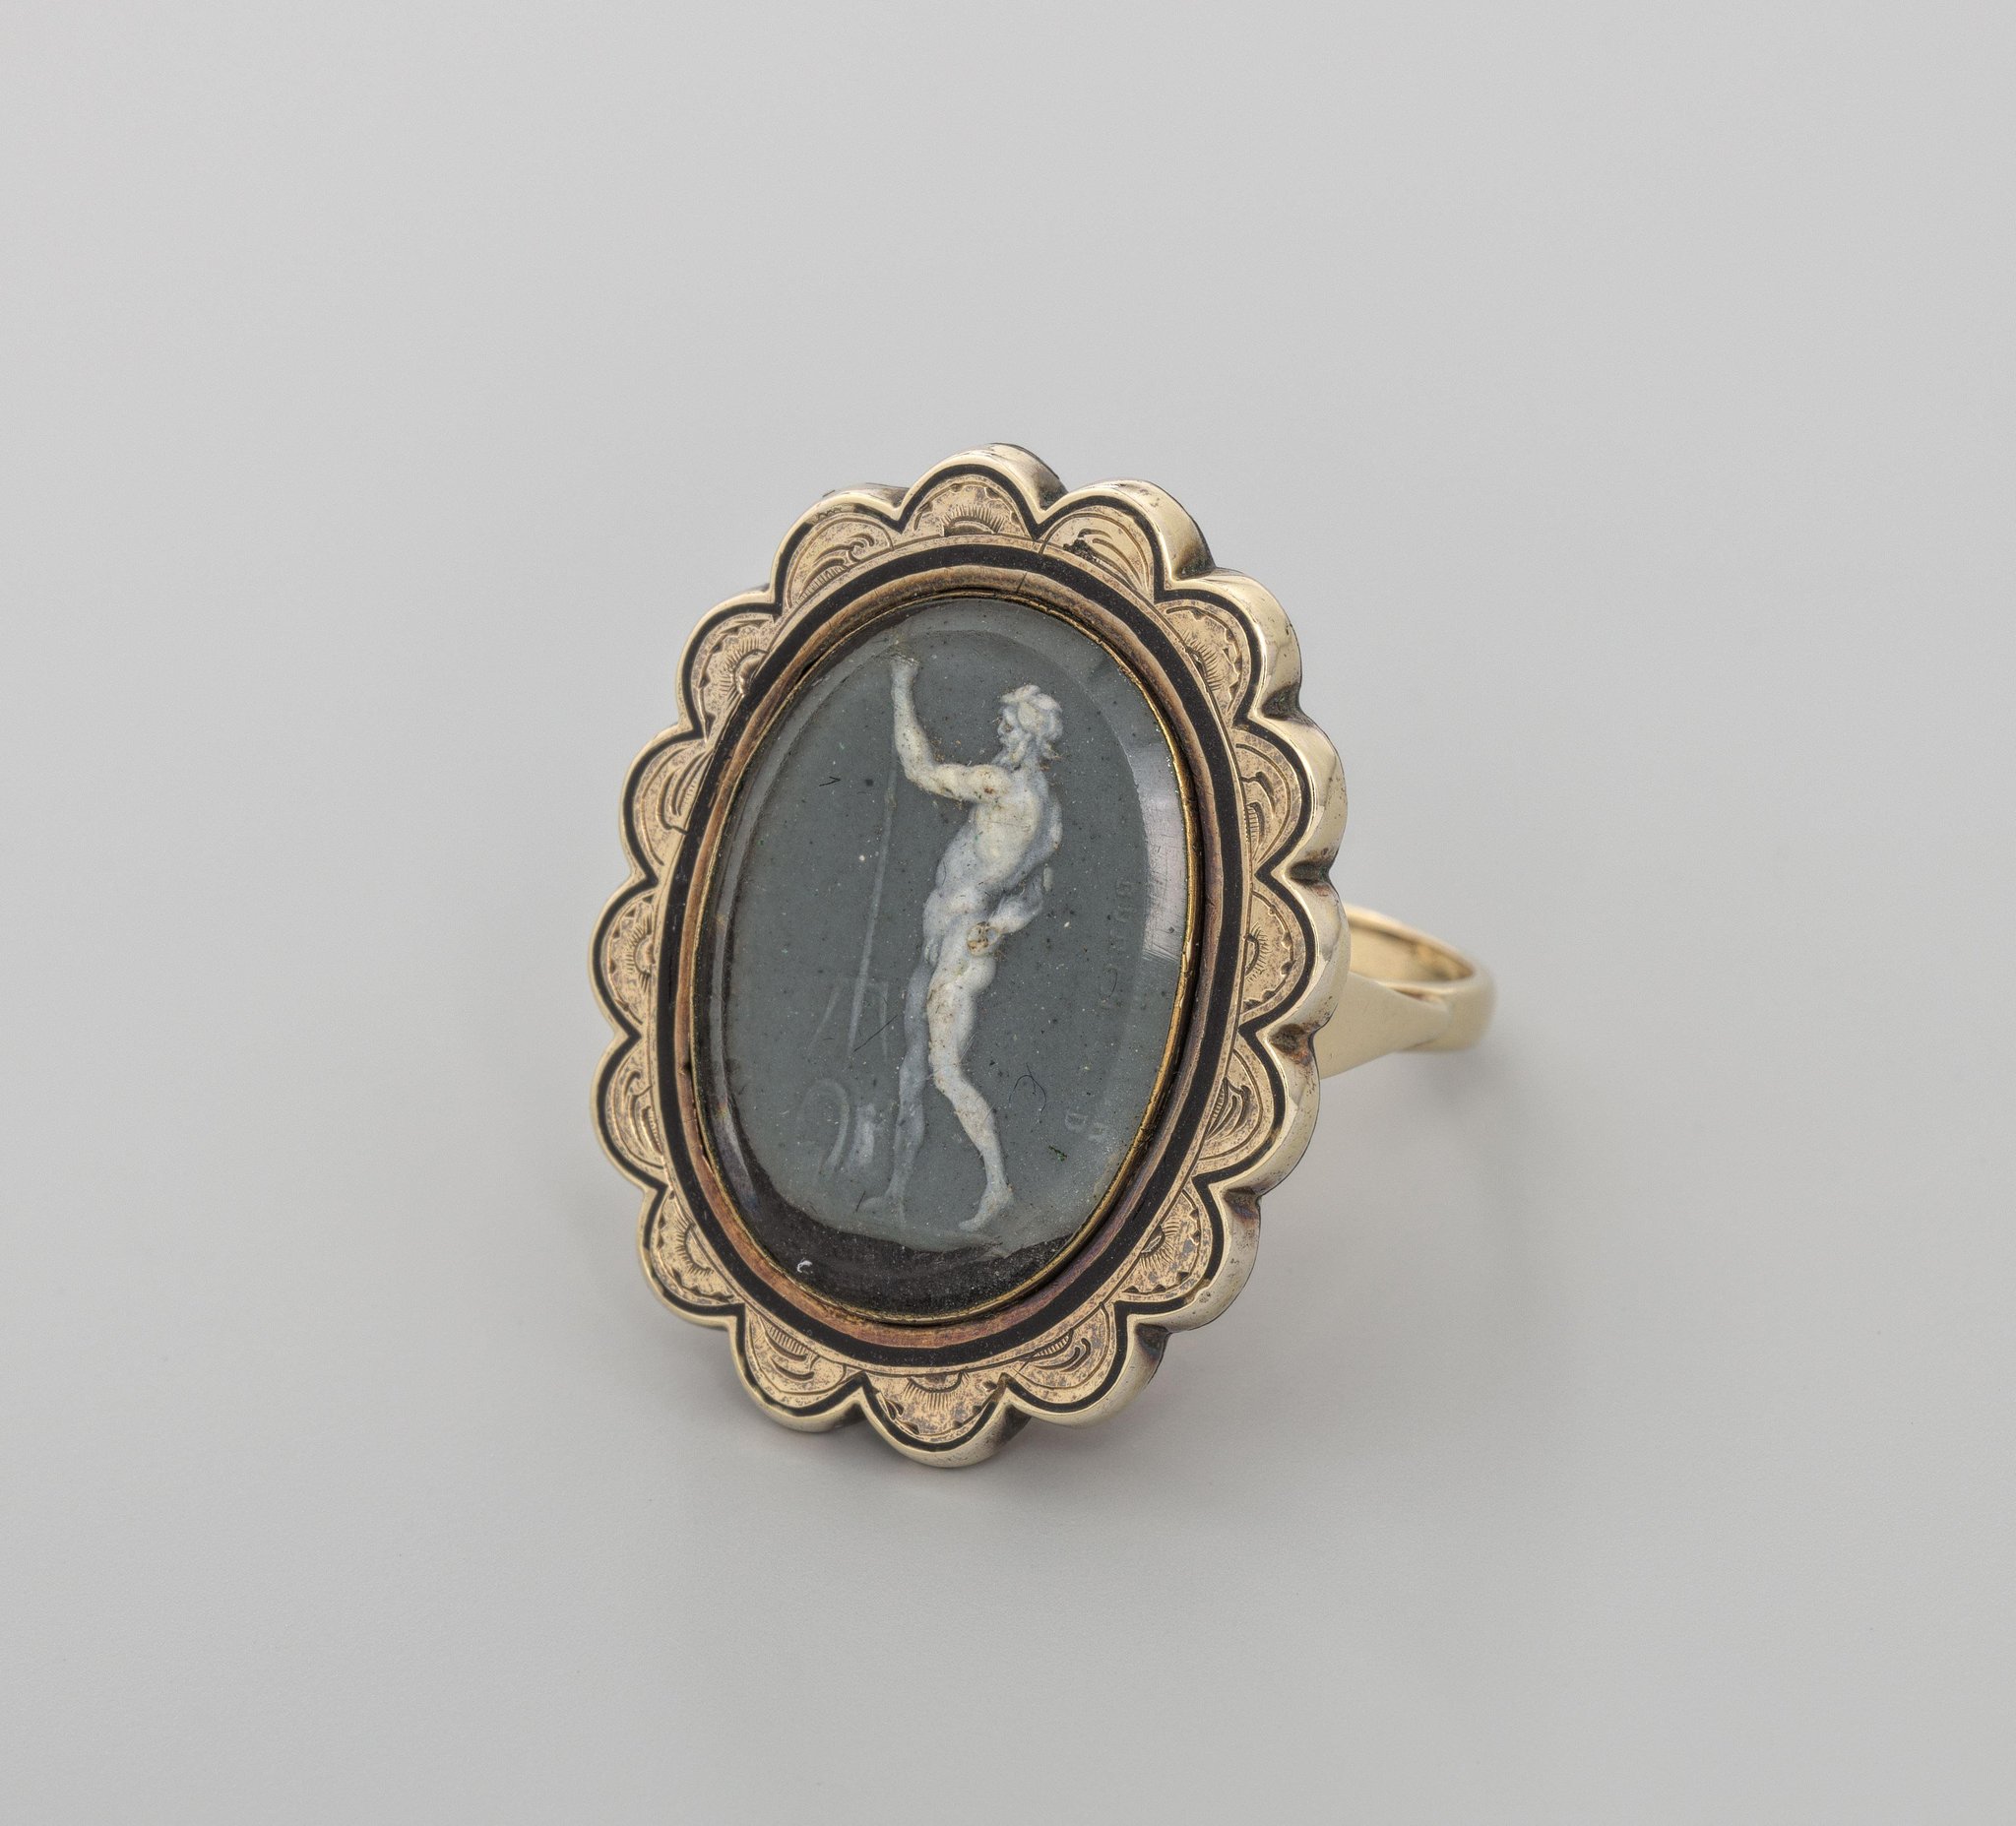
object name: ring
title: Ring van goud met camee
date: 1800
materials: gold, wax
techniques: engraving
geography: england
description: Dit ovaal medaillon is later vermaakt tot ring. In de camee staat Neptunus met een drietand.